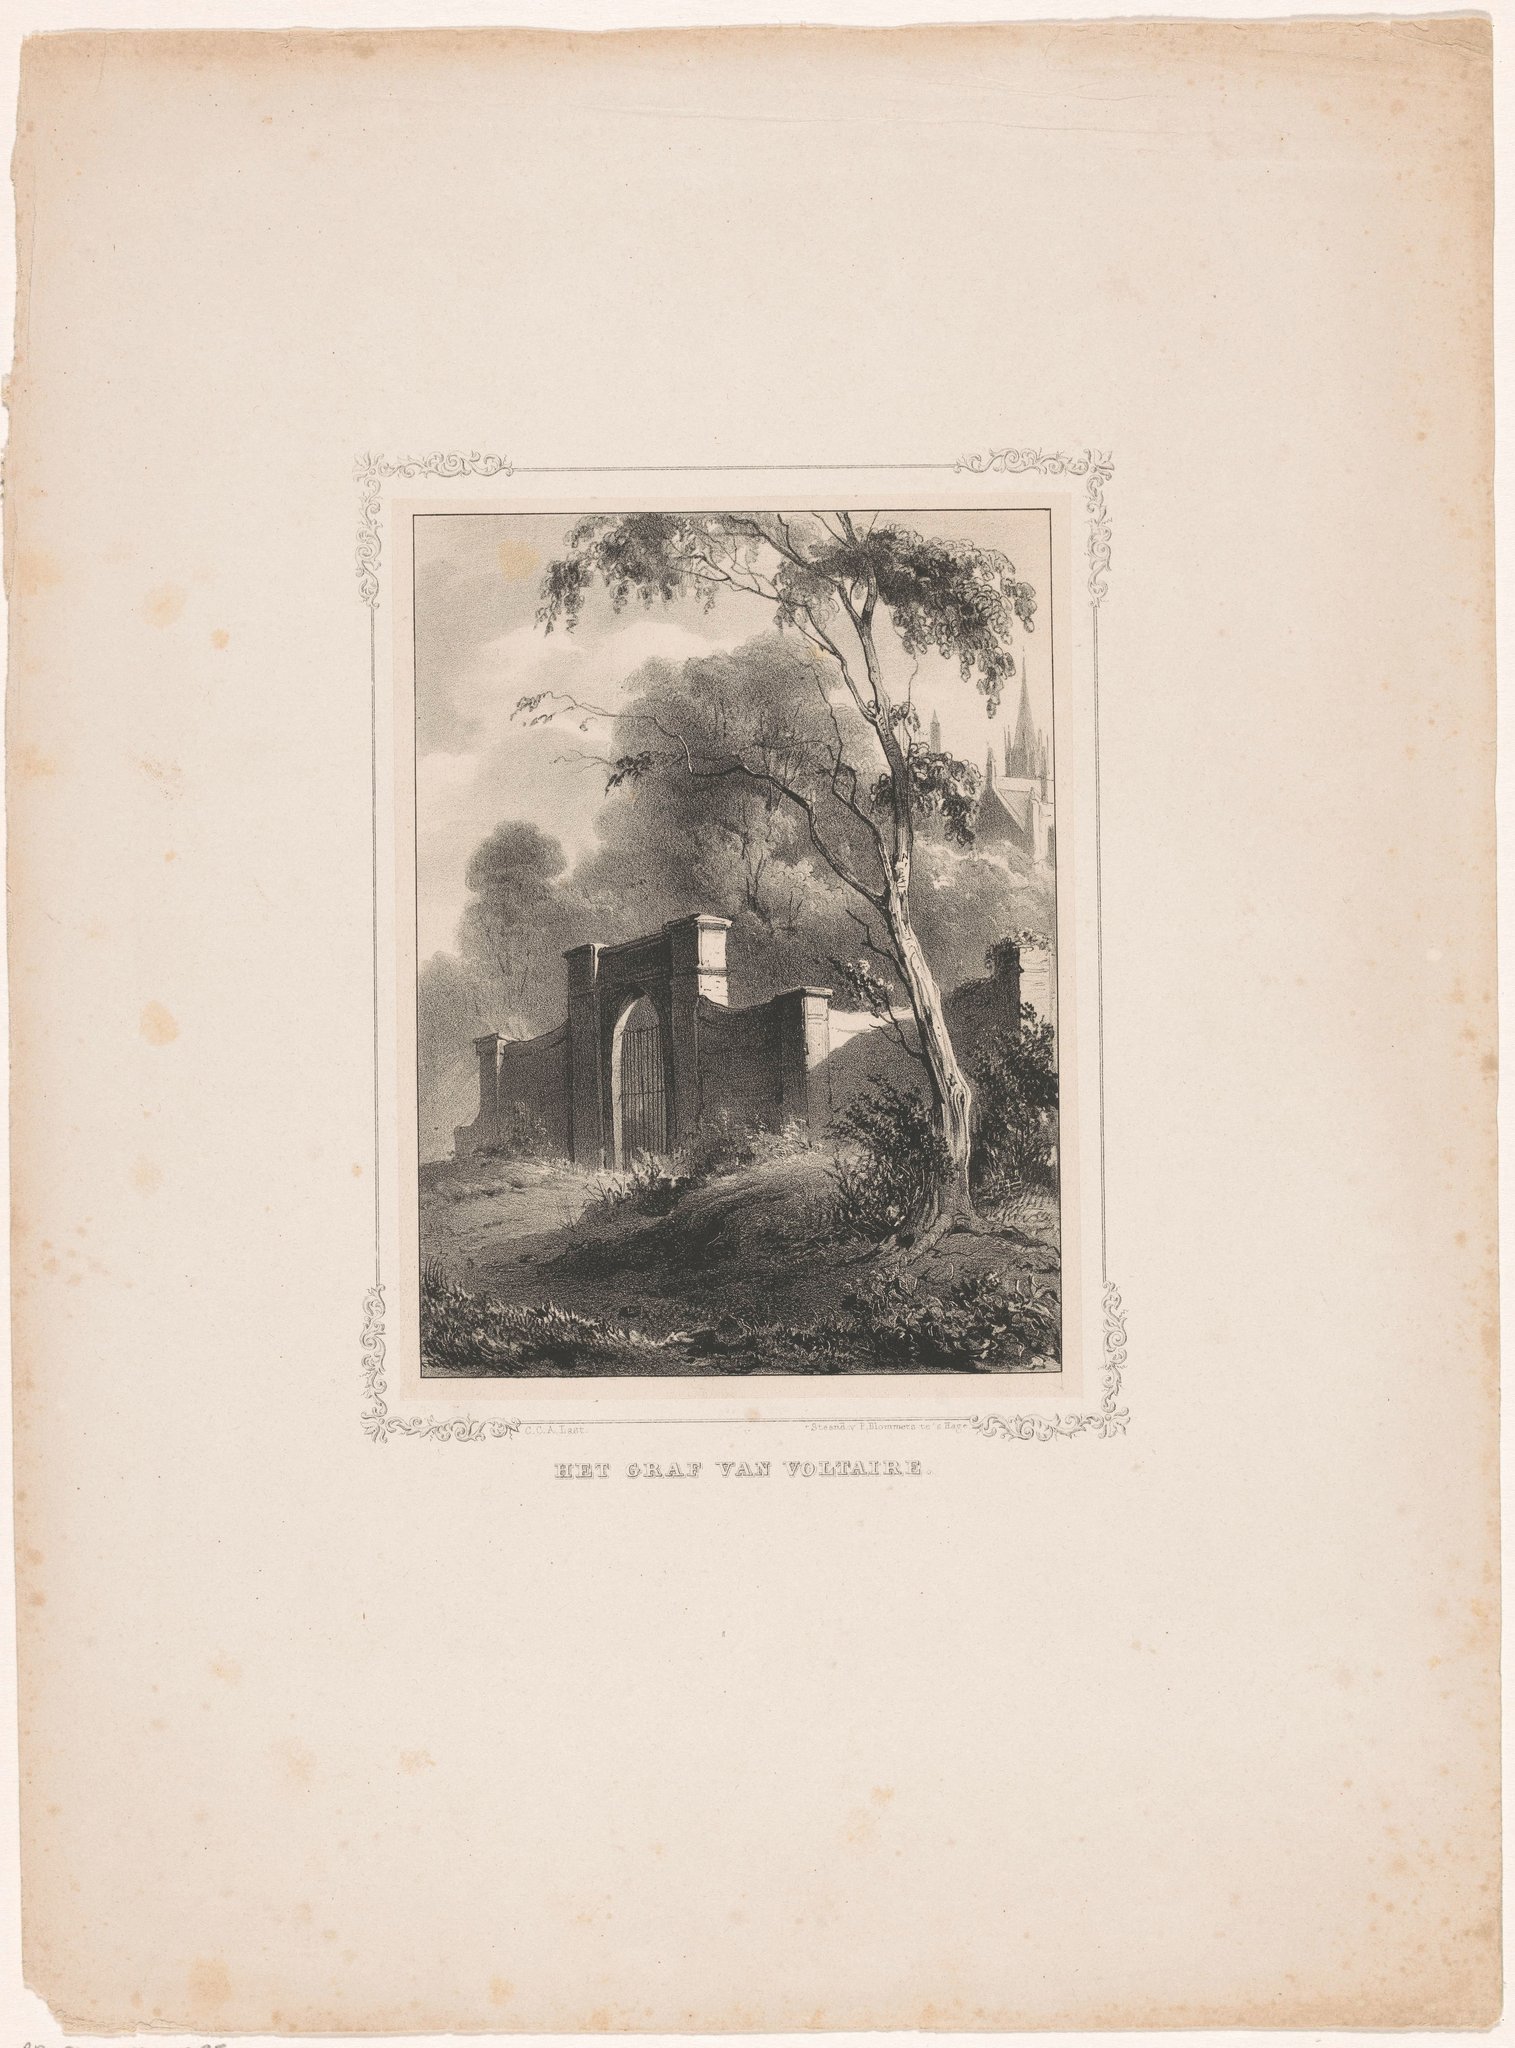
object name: print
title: Het graf van Voltaire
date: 1842-1887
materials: paper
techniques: lithograph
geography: the hague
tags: paris, voltaire, cemetery, park-like burying ground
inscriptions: collector's mark: Lugt 2228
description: Het lichaam van Voltaire werd later, in 1791, verplaatst naar het Pantheon in Parijs.